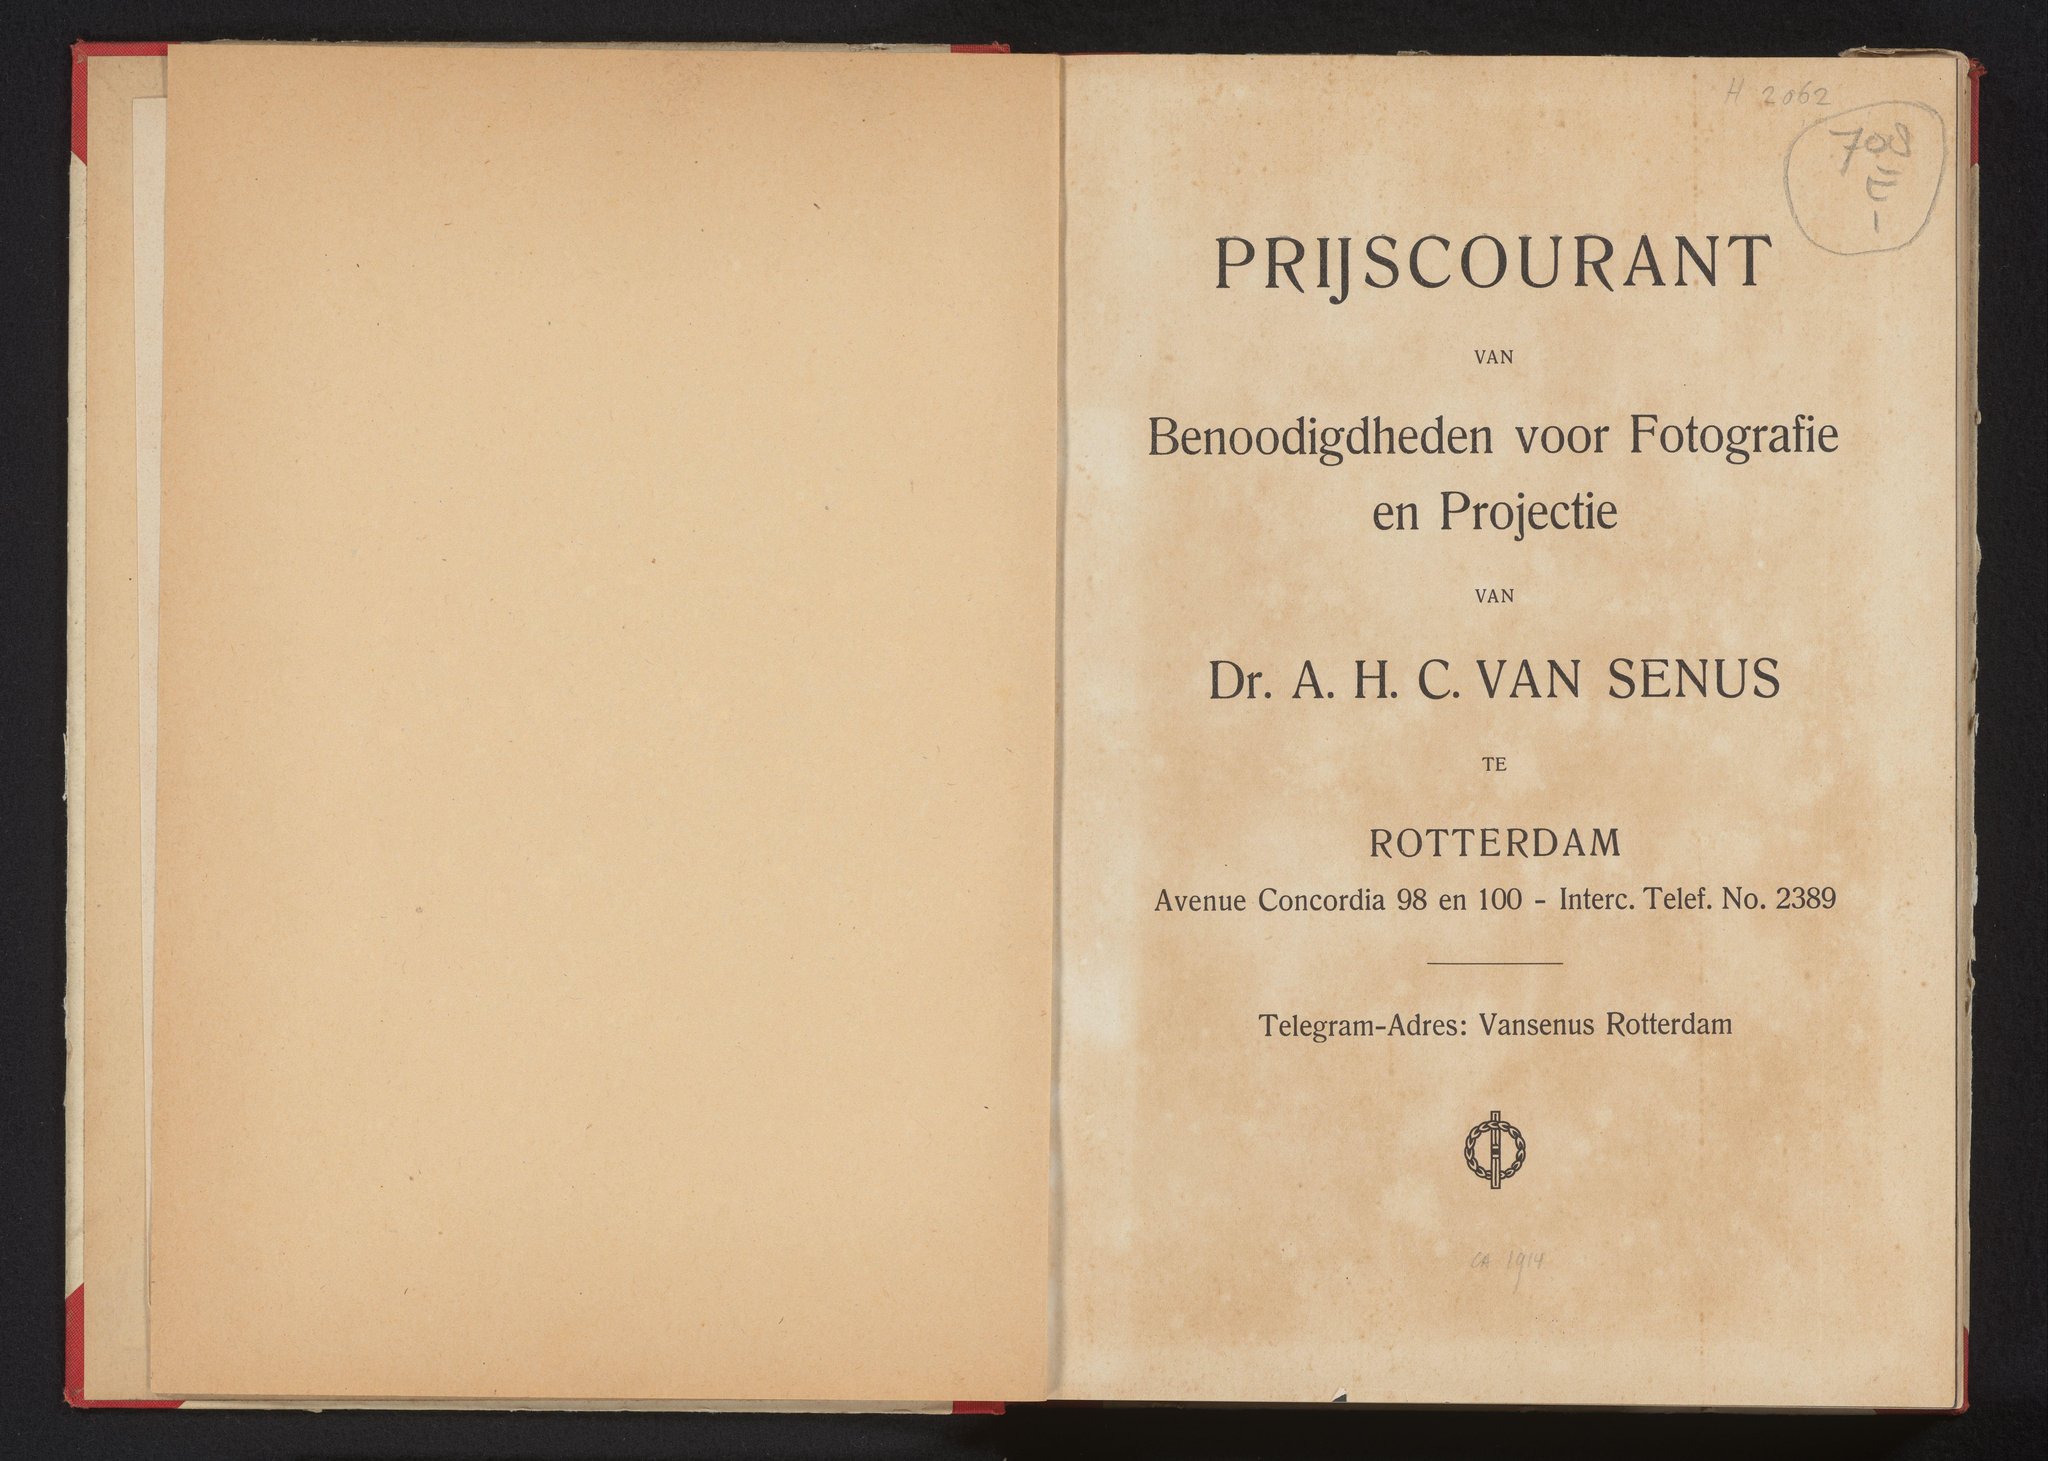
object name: book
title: Prijscourant van benoodigdheden voor fotografie en projectie van dr. A.H.C. van Sensus te Rotterdam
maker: antonie hendrikus catharinus van senus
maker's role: apotheker, fotograaf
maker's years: 1865-1933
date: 1914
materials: paper, cardboard, linen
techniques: gelatin silver print, letterpress printing, engraving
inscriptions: inscription: ‘CA 1914’, inscription: ‘(...)’, inscription: ‘(...)’